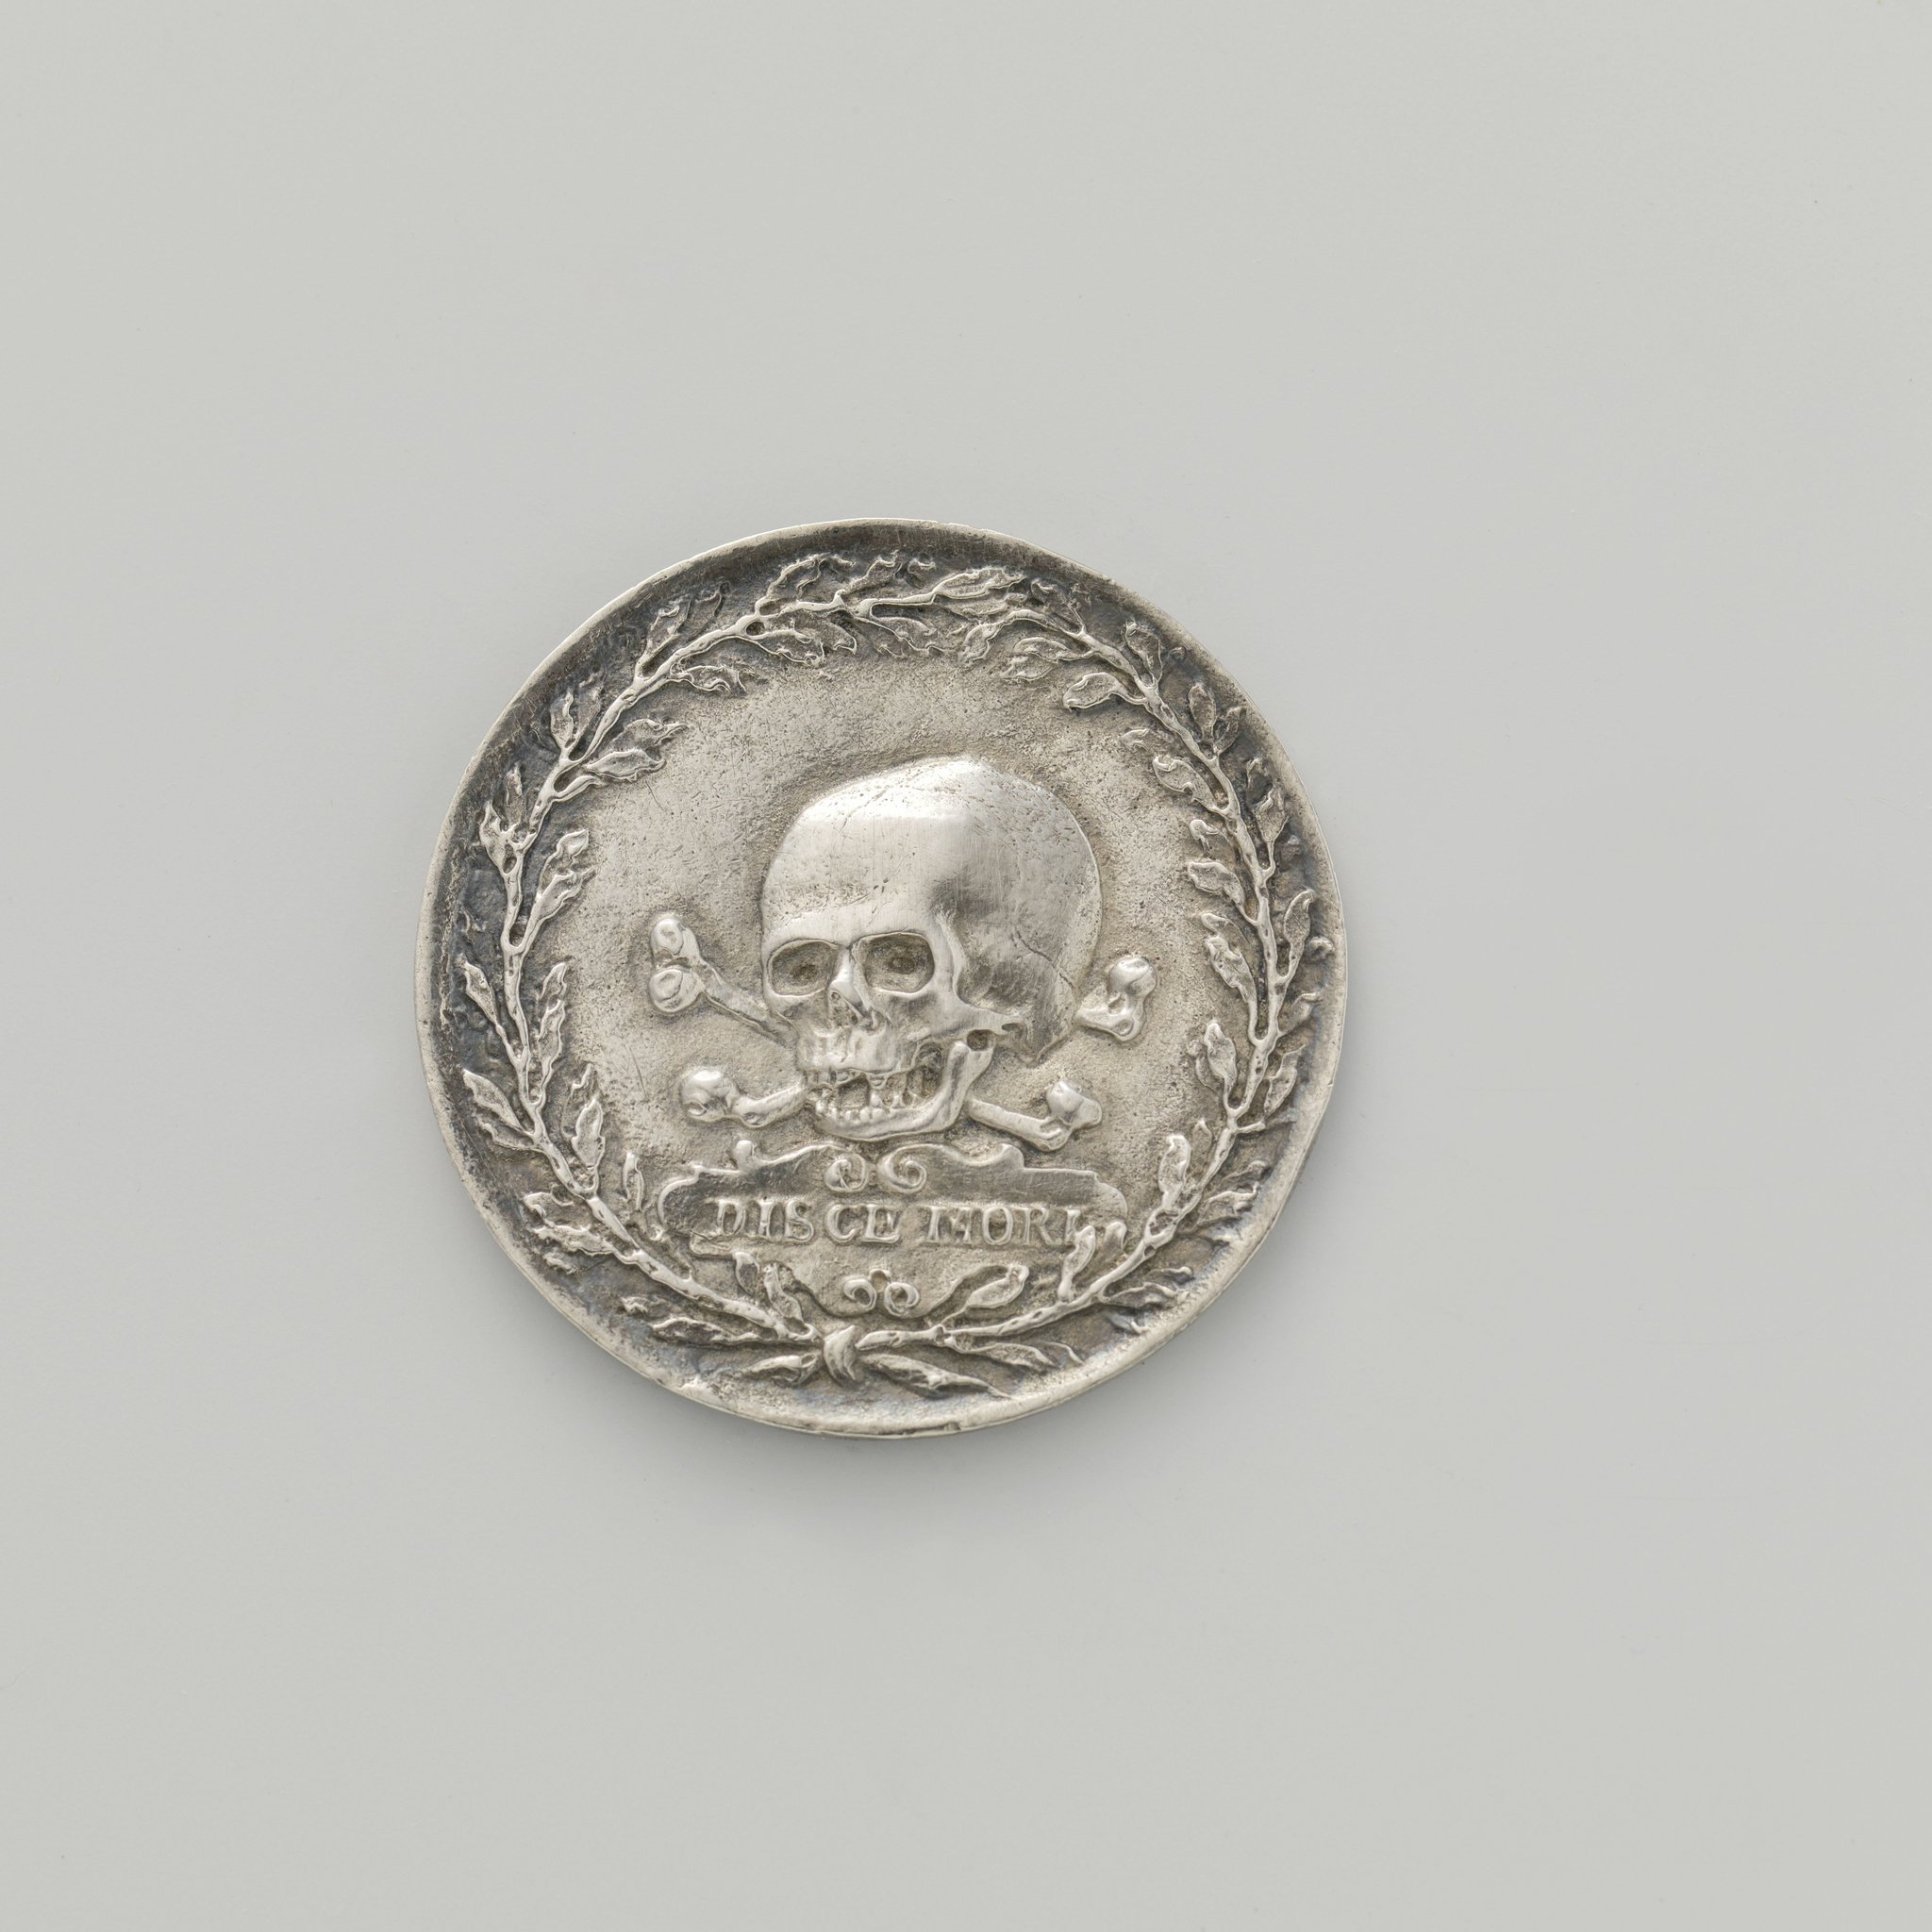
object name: medal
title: Wine Merchants’ Guild, with the name of Lucas Bols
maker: Anonymous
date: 1621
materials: silver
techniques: casting, engraving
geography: amsterdam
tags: amsterdam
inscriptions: inscription: ‘LUCAS BOLS’, inscription: ‘DISCE MORI’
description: Zilveren penning. Voorzijde: binnen een krans, gevormd door twee lauriertakken, een schedel, driekwart frontaal naar links geplaatst voor twee gekruiste beenderen. Daaronder een cartouche met opschrift. Keerzijde: binnen een vrij brede gladde rand een roemer waarboven een wijnrank. Van deze rank hangt een druiventros af precies boven het glas. Op de tafel = afsnede het jaartal 1621. Bovenaan in gladde rand opschrift.